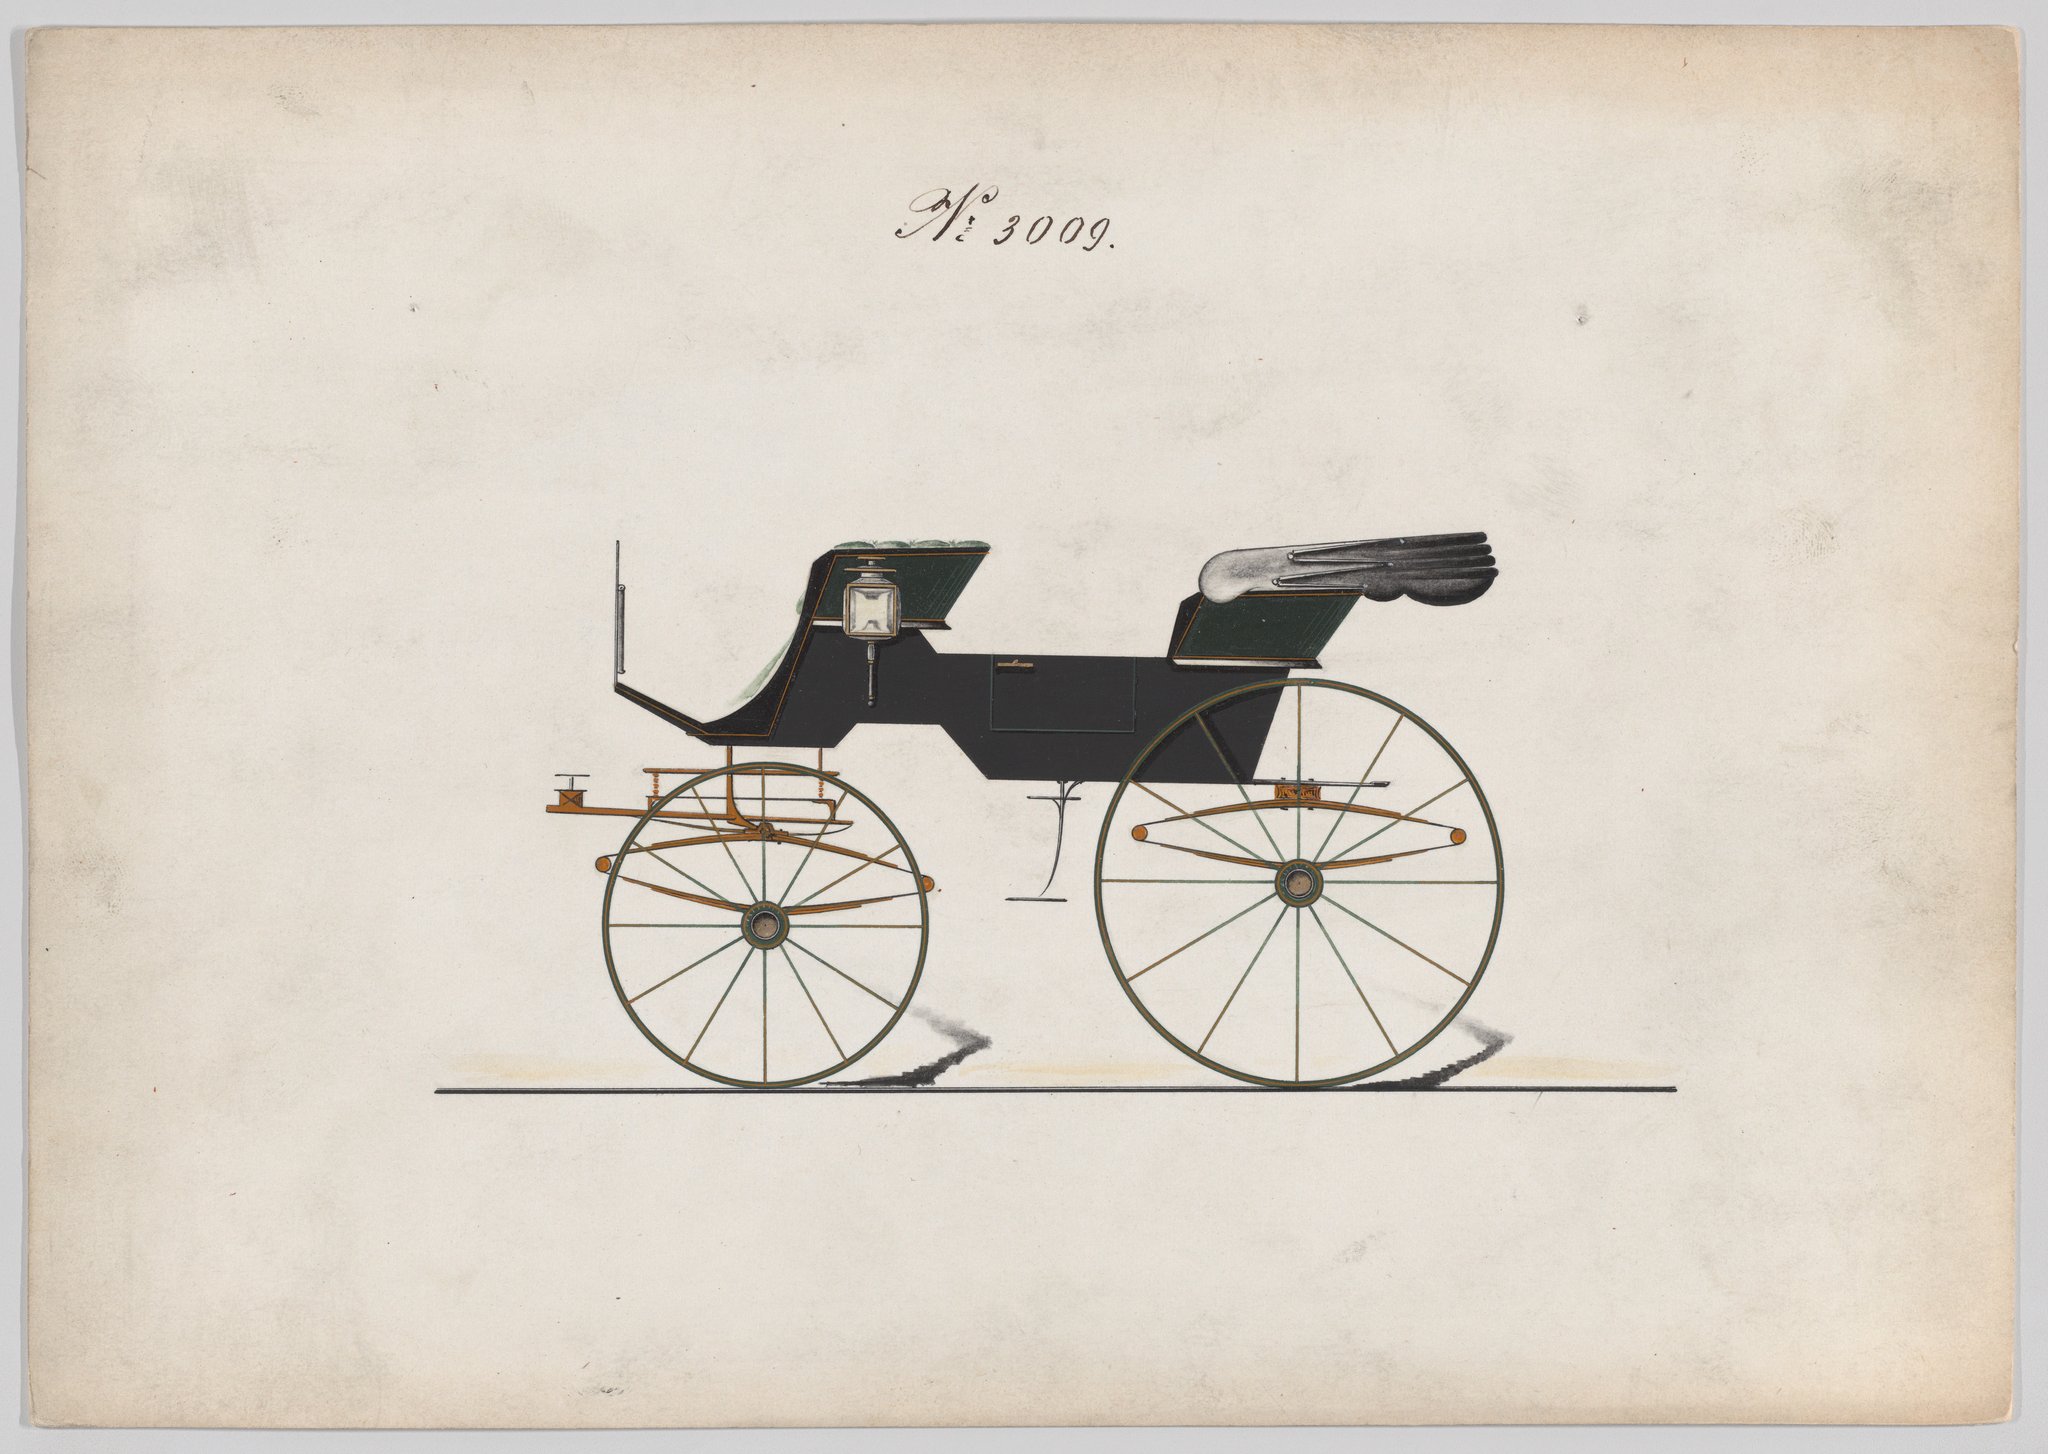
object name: drawing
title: Design for 2 seat Phaeton, no. 3009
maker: brewster & co.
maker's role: manufacturer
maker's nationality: american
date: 1874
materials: gouache, gum arabic, ink, watercolor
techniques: pen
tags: carriages